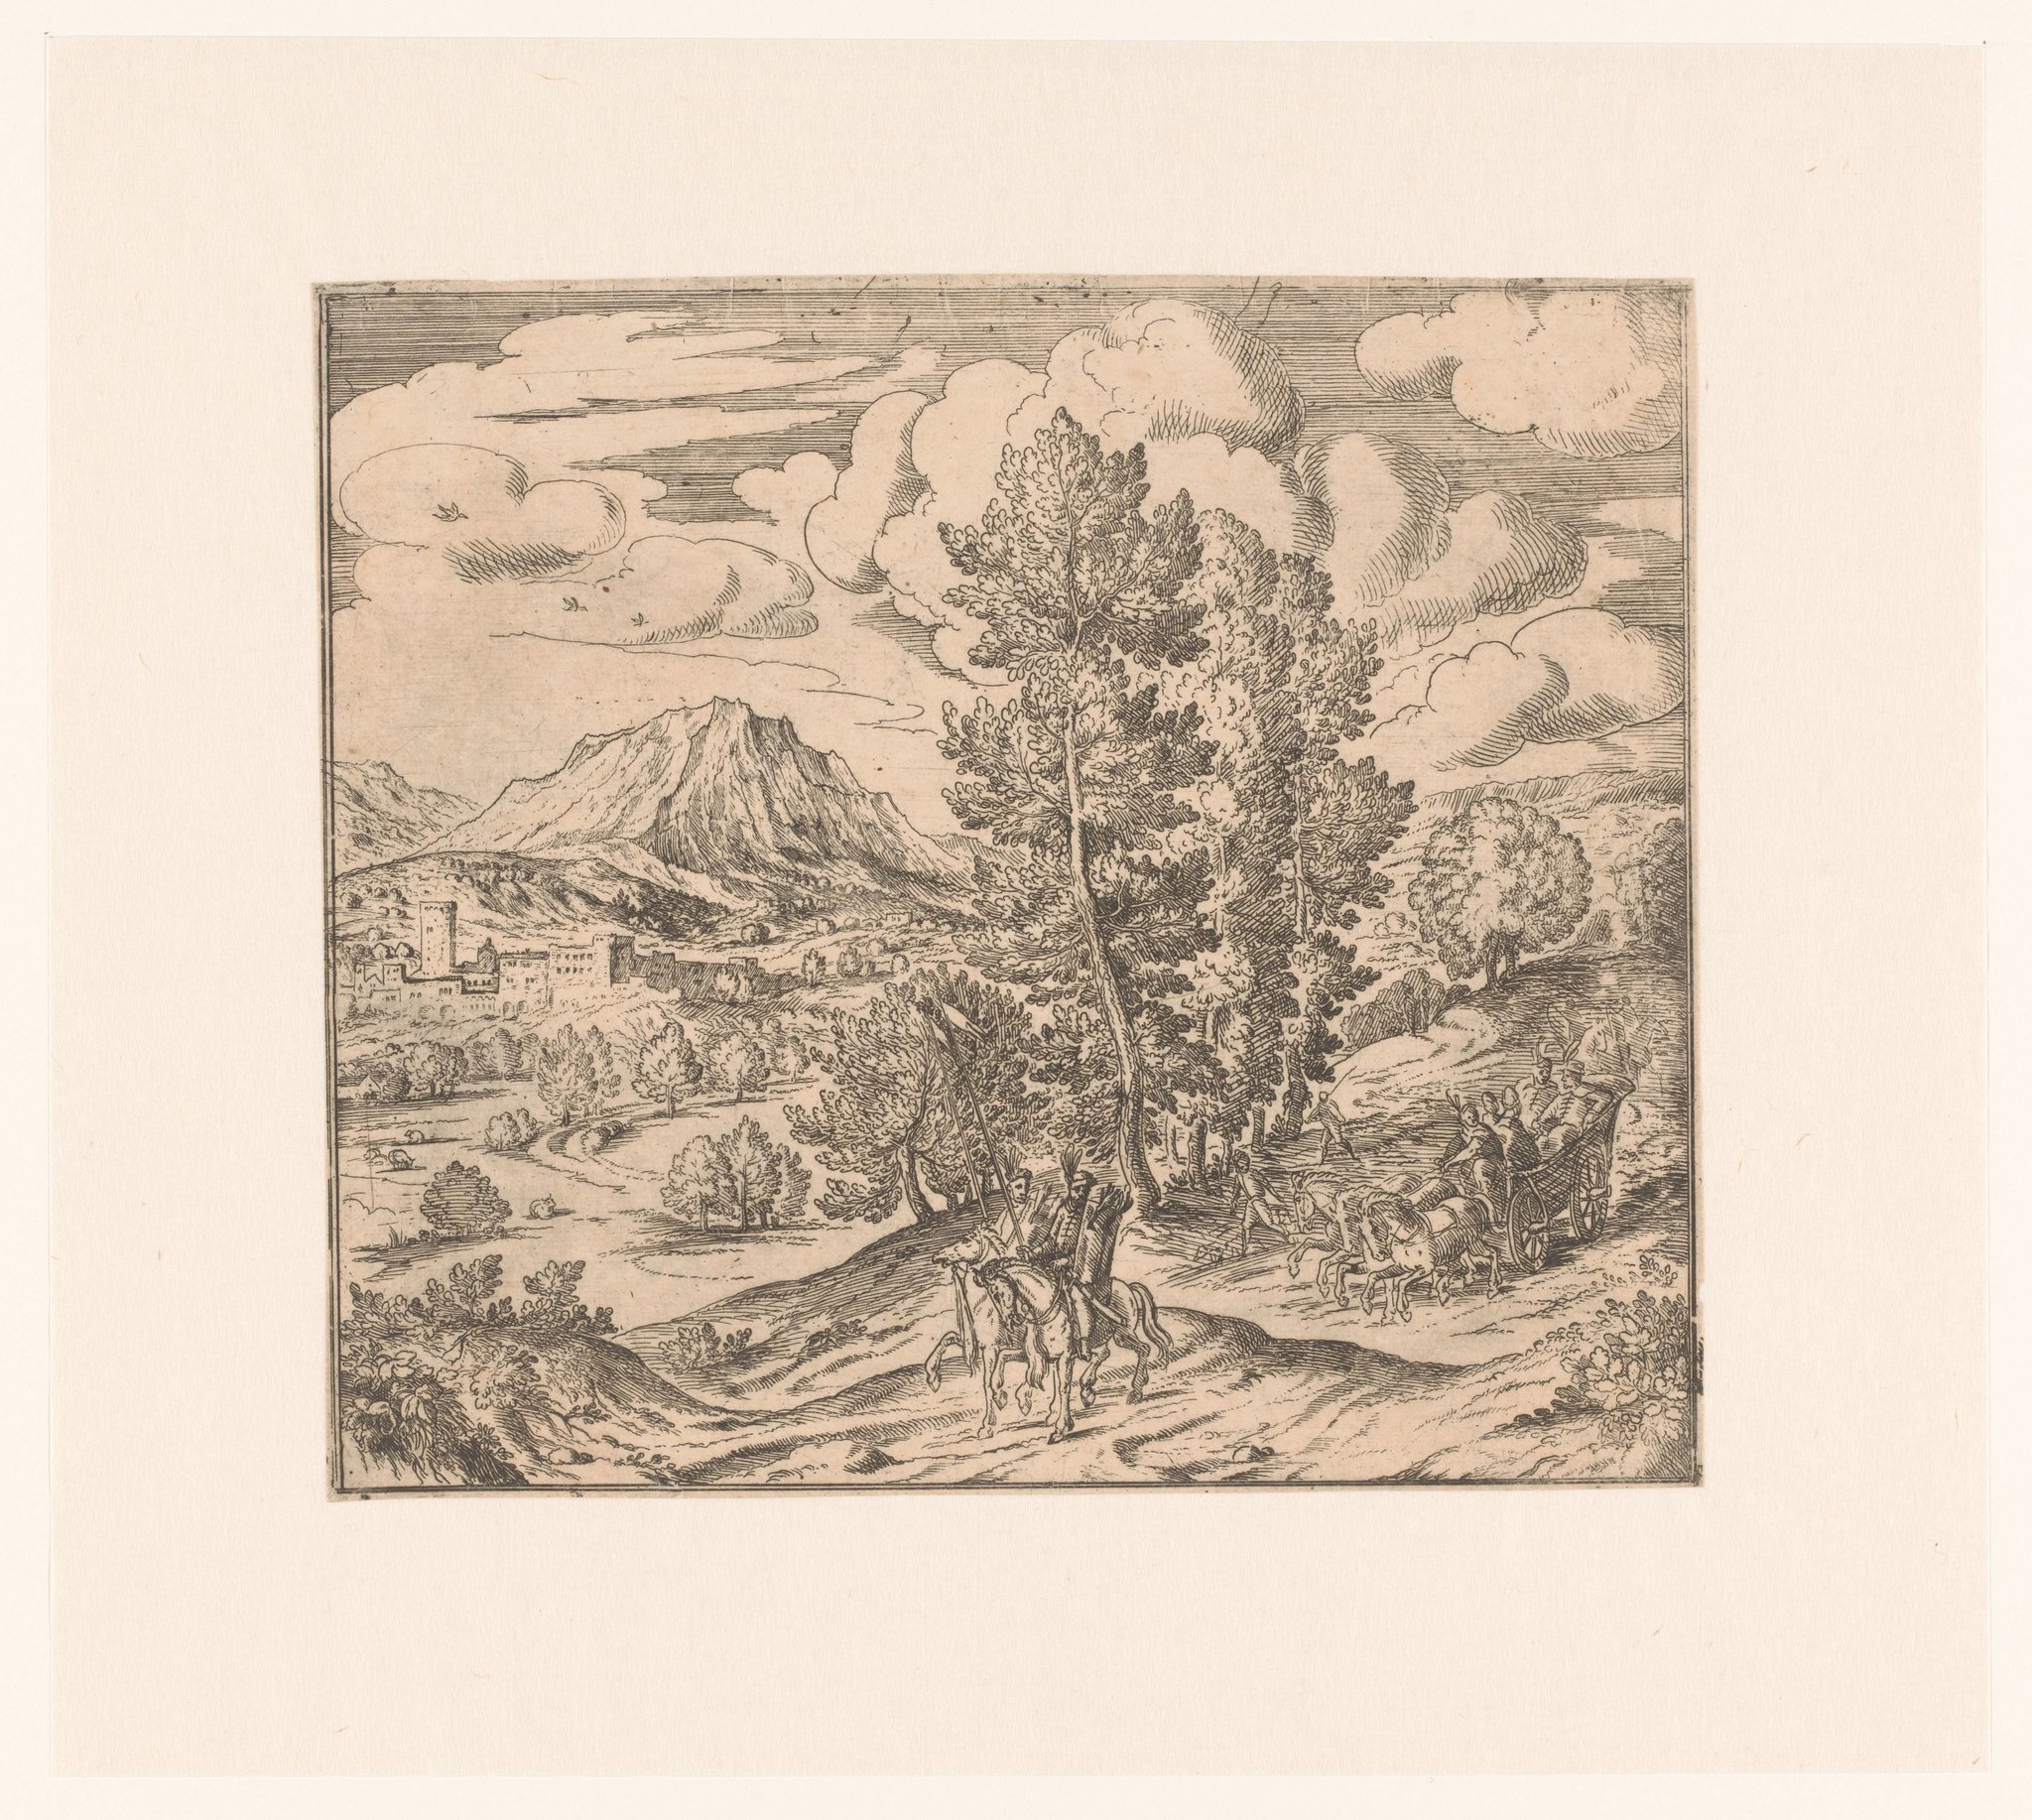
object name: print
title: Landschap met twee ruiters en een reiswagen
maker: Anonymous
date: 1560-1600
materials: paper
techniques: etching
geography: france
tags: four-wheeled vehicle drawn by three animals, landscapes in the temperate zone, 'en route', traveller under way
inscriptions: collector's mark: Lugt 2760, watermark, collector's mark: ‘Graph. Sammlung Dr. ?’, collector's mark: Lugt 2228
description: Een heuvelachtig landschap met op de achtergrond links een stad. Midden op de voorgrond bevinden zich twee ruiters gewapend met lansen en schilden. Zij lijken het gezelschap in een open reiswagen rechts achter te escorteren.